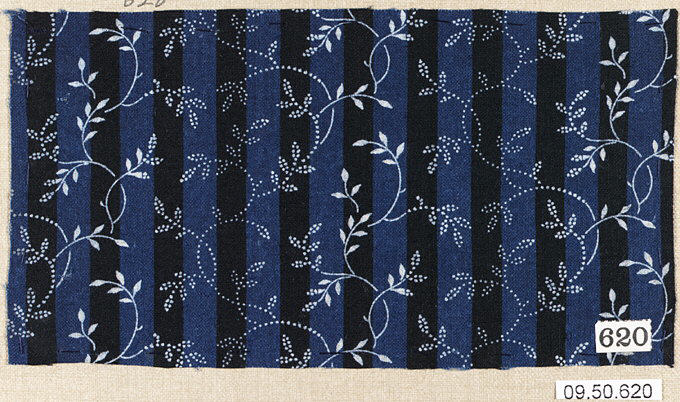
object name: piece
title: Pieces (6)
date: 1801-1900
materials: cotton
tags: leaves